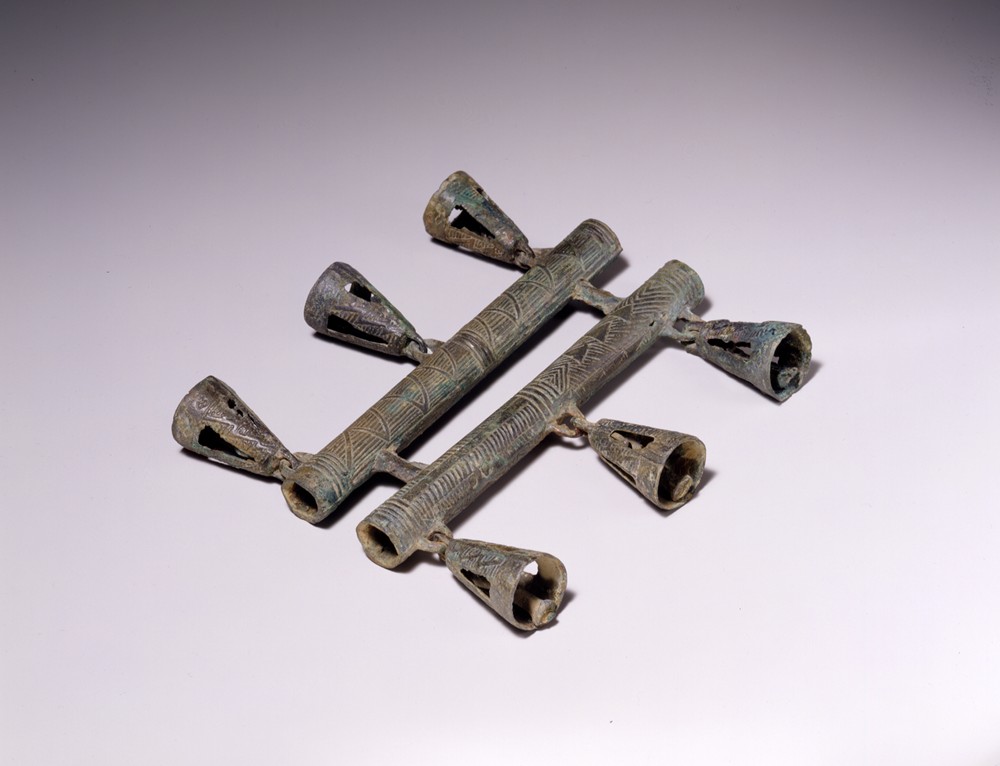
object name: ornament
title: Ornament with Six Bells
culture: north chinese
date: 1000-668 BCE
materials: bronze